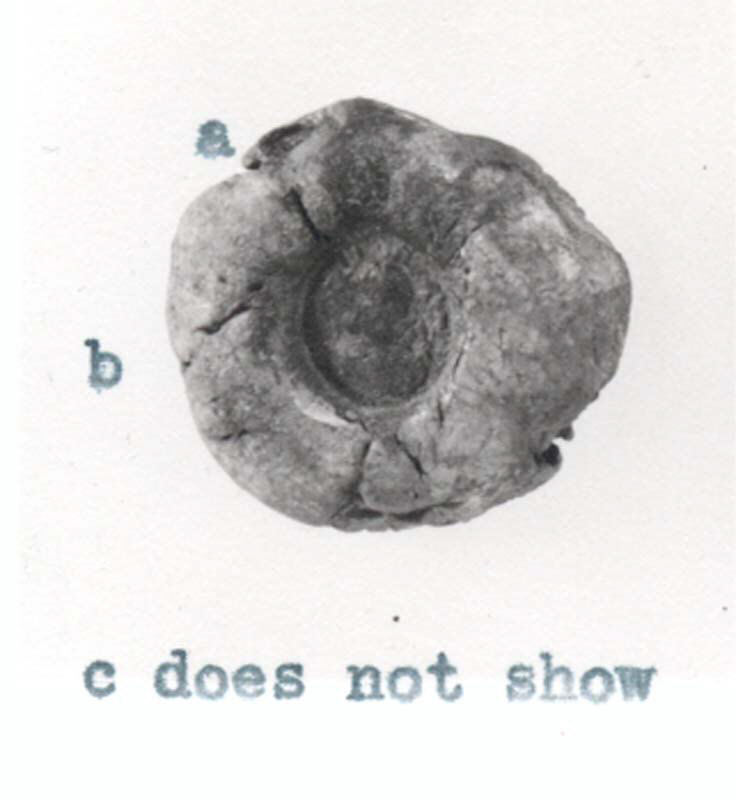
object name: sealing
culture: sasanian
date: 601-700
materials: clay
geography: iran